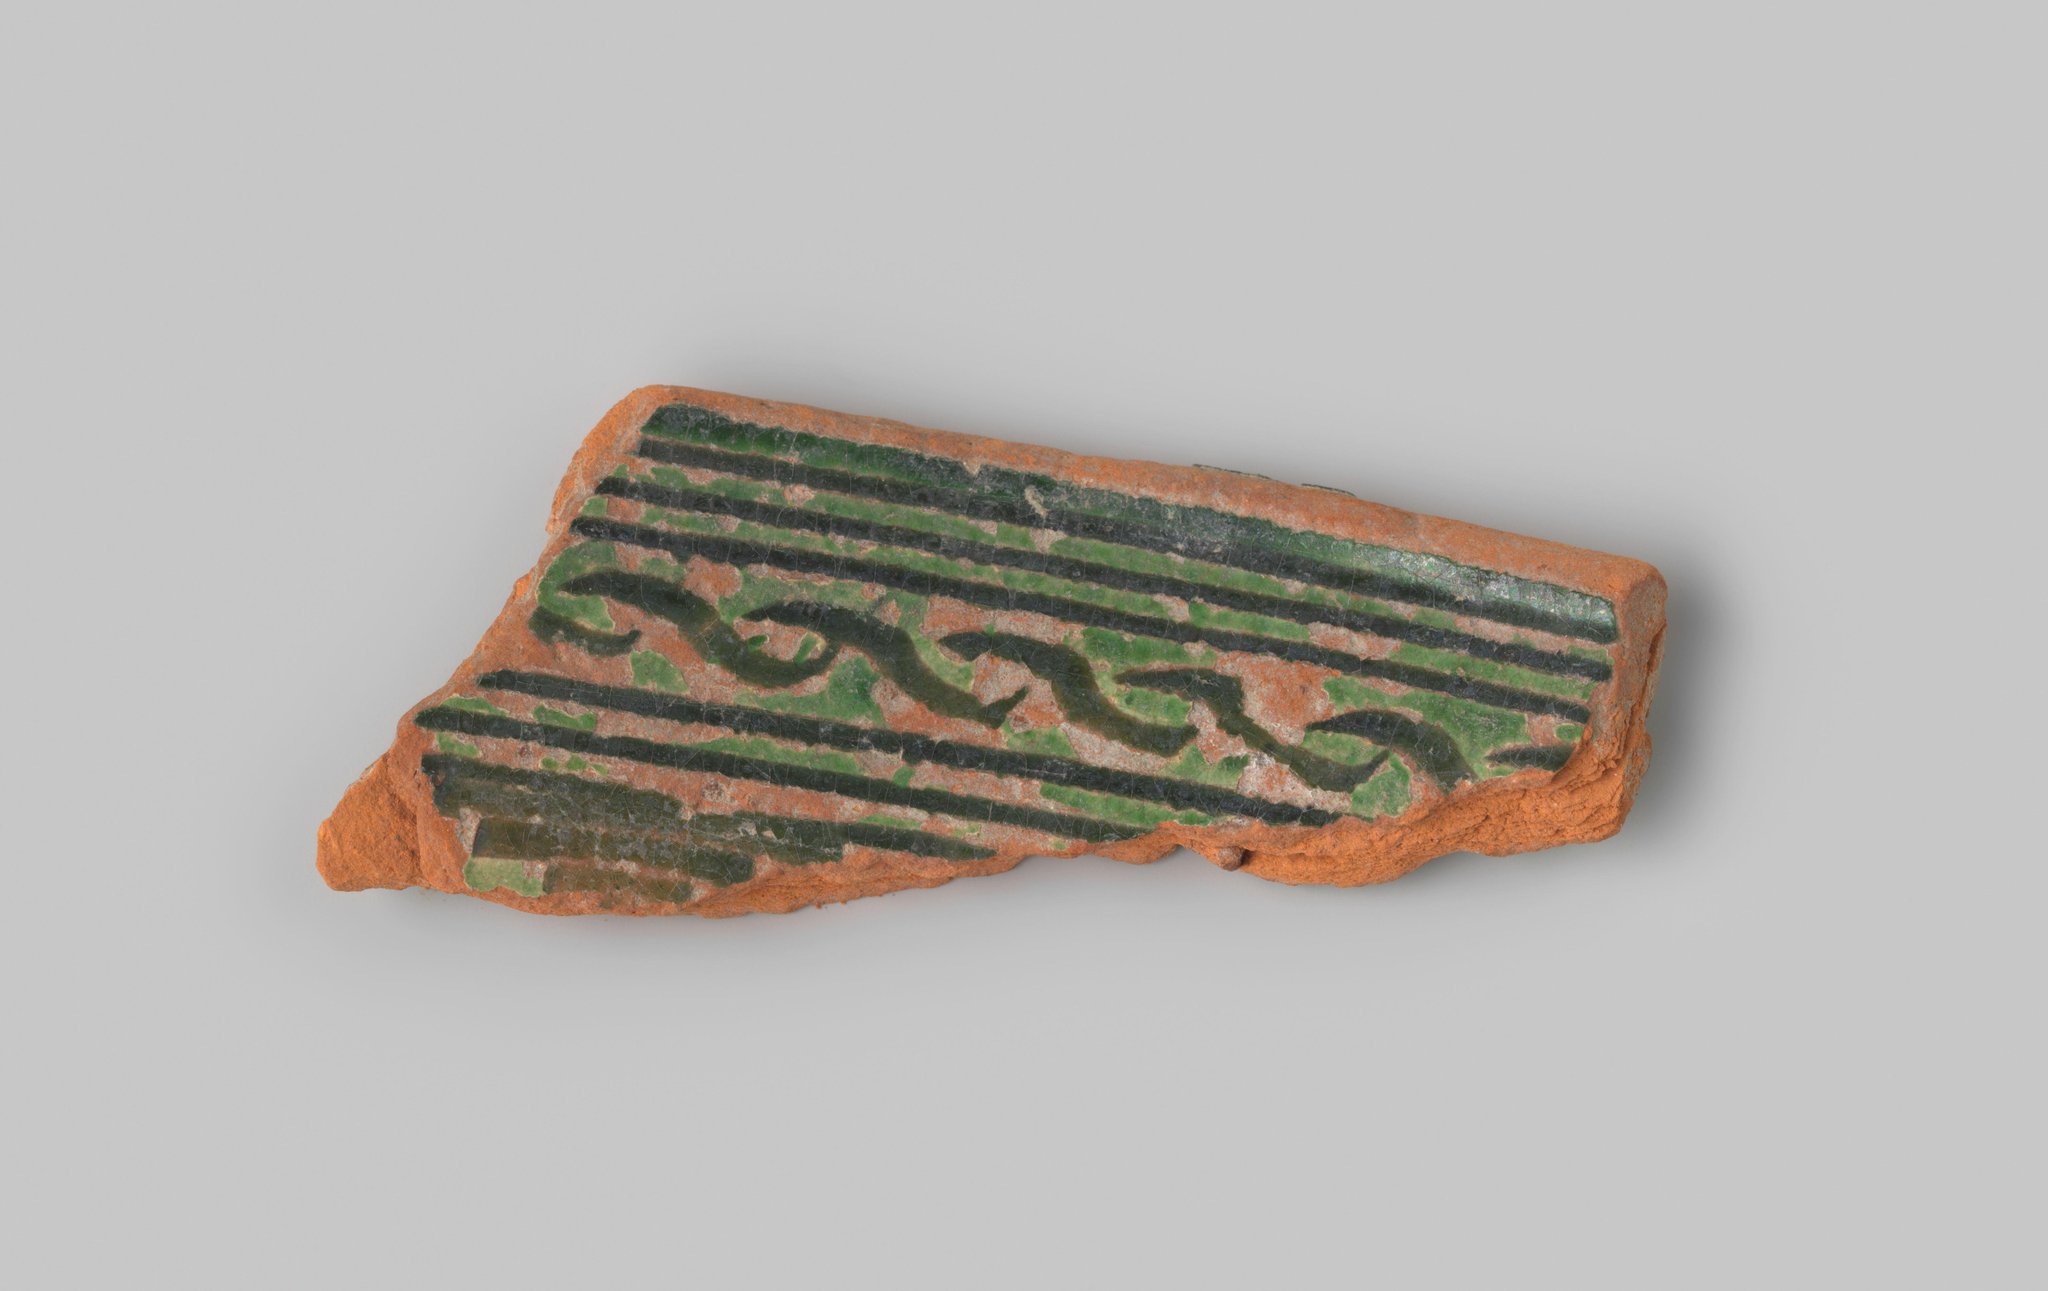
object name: sherd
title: Fragment van een schotel met roodbakkende scherf, met aan de voor- en achterzijde groen glazuur, waarop in sgrafitto-techniek met zwart strepen zijn aangebracht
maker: Anonymous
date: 1200-1899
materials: earthenware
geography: italy